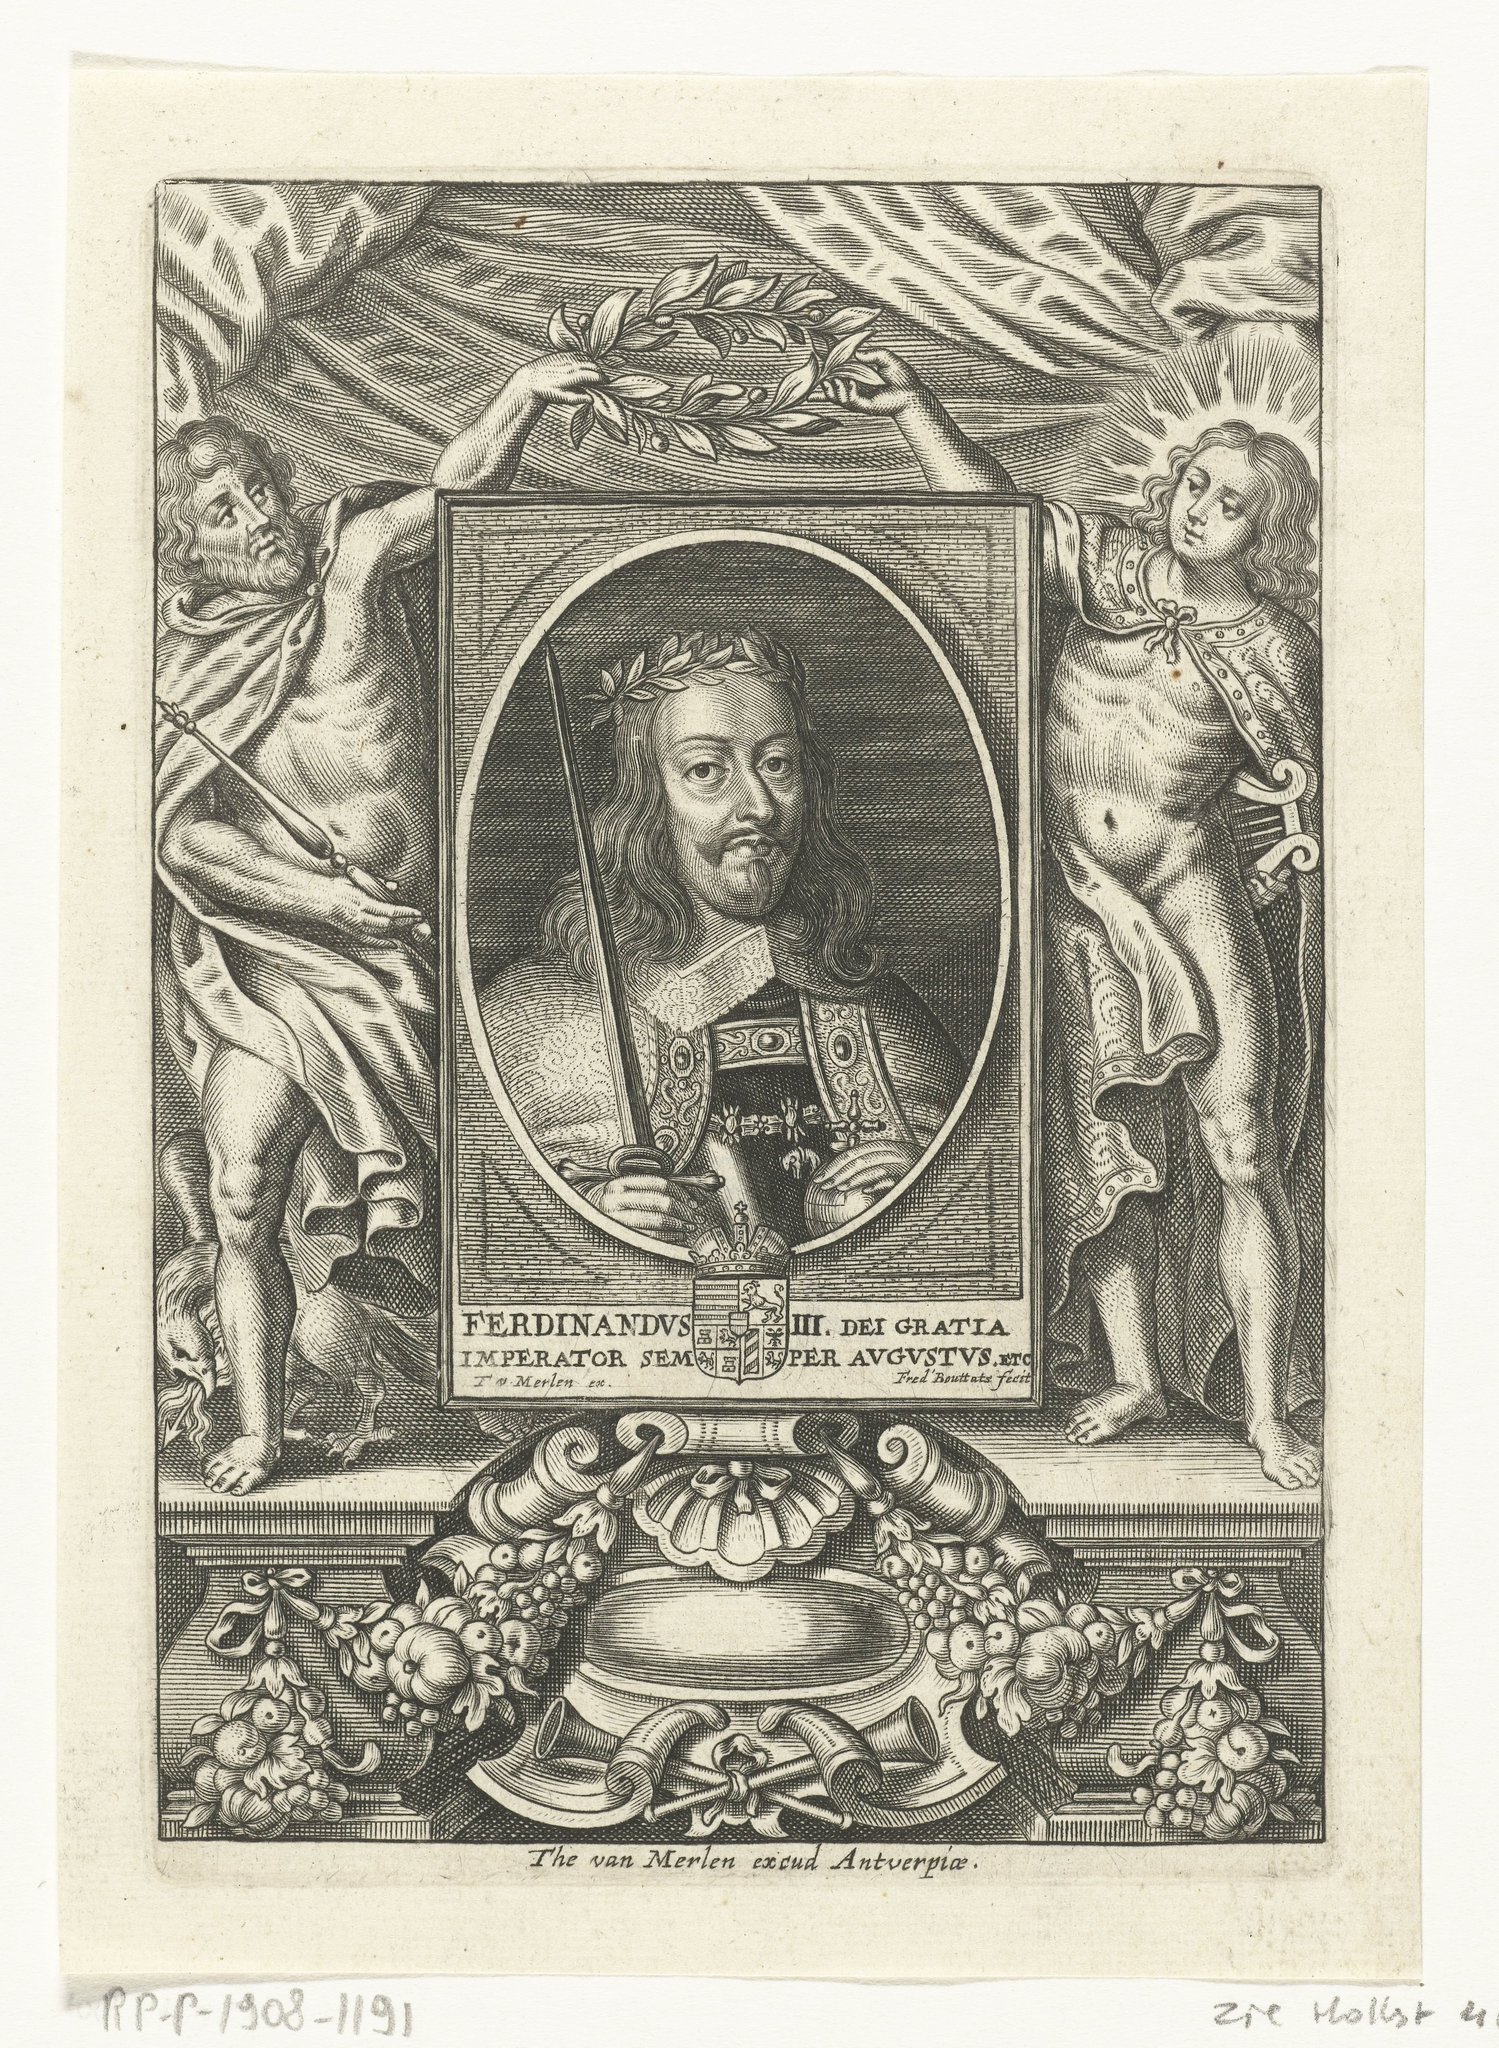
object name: print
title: Portretten van staatslieden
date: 1637-1676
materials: paper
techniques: engraving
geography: antwerp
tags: vienna, ferdinand iii (duits keizer), (story of) apollo (phoebus), (story of) jupiter (zeus)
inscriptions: collector's mark: Lugt 2228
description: Portret in een ovale lijst van Ferdinand III, aartshertog van Oostenrijk en keizer van het Heilig Roomse Rijk. Buste naar rechts. Ferdinand draagt de lauwerkrans op zijn hoofd. In zijn handen de rijksappel en het rijkszwaard.. Het portret staat in een rechthoekig kader tussen twee klassieke goden, Jupiter en Apollo. Ze houden een lauwerkrans boven het portret.. De prent heeft een Latijns onderschrift met de naam van de geportretteerde.